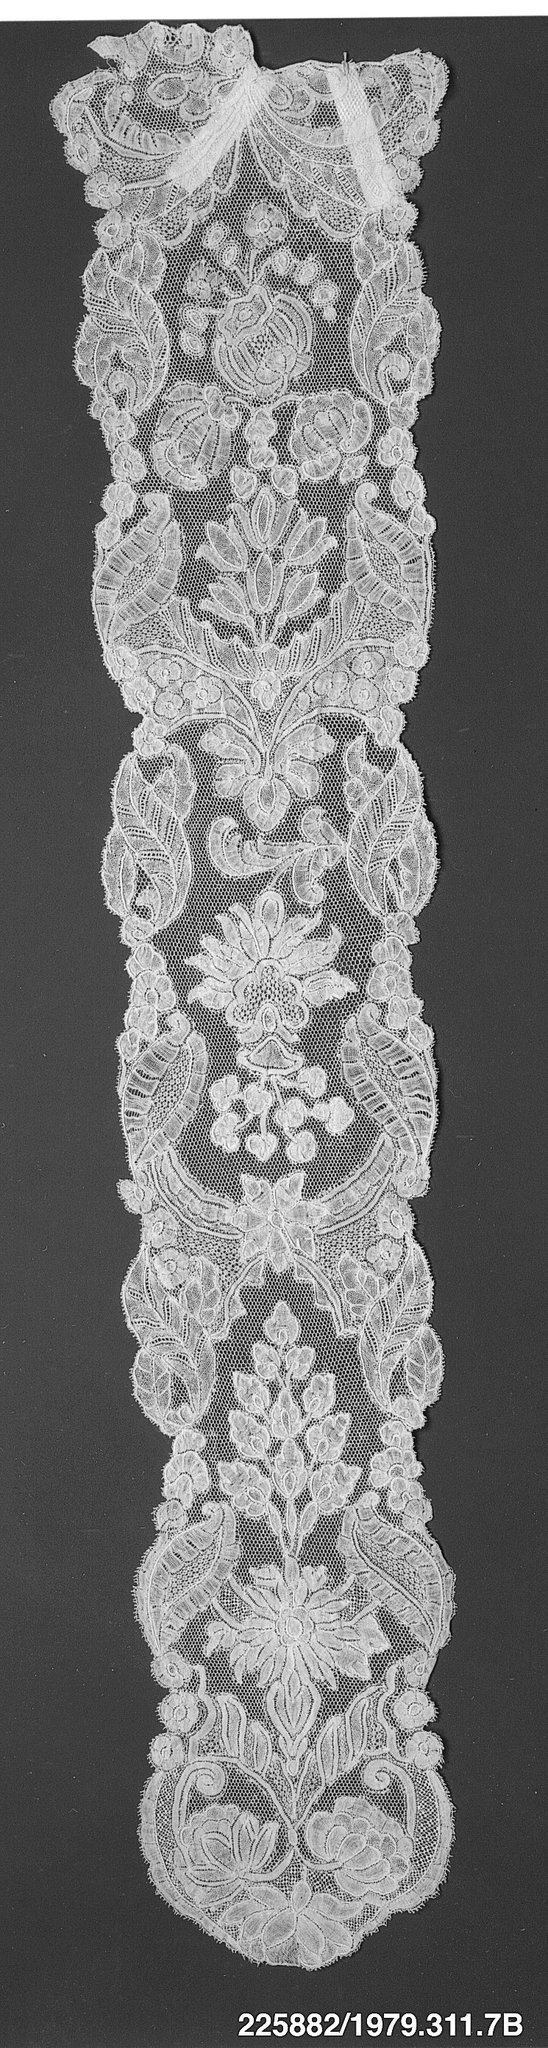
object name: lappet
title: Pair of lappets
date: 1734-1766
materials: lace, linen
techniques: lace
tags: flowers